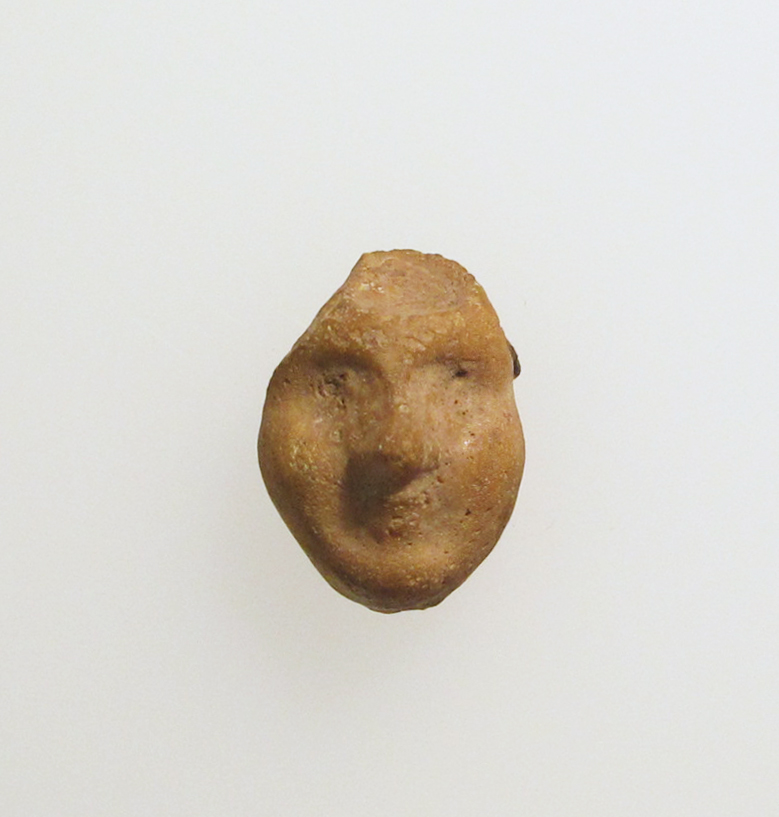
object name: head pendant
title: Glass head pendant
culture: carthaginian or phoenician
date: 300-101 BCE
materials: glass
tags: heads